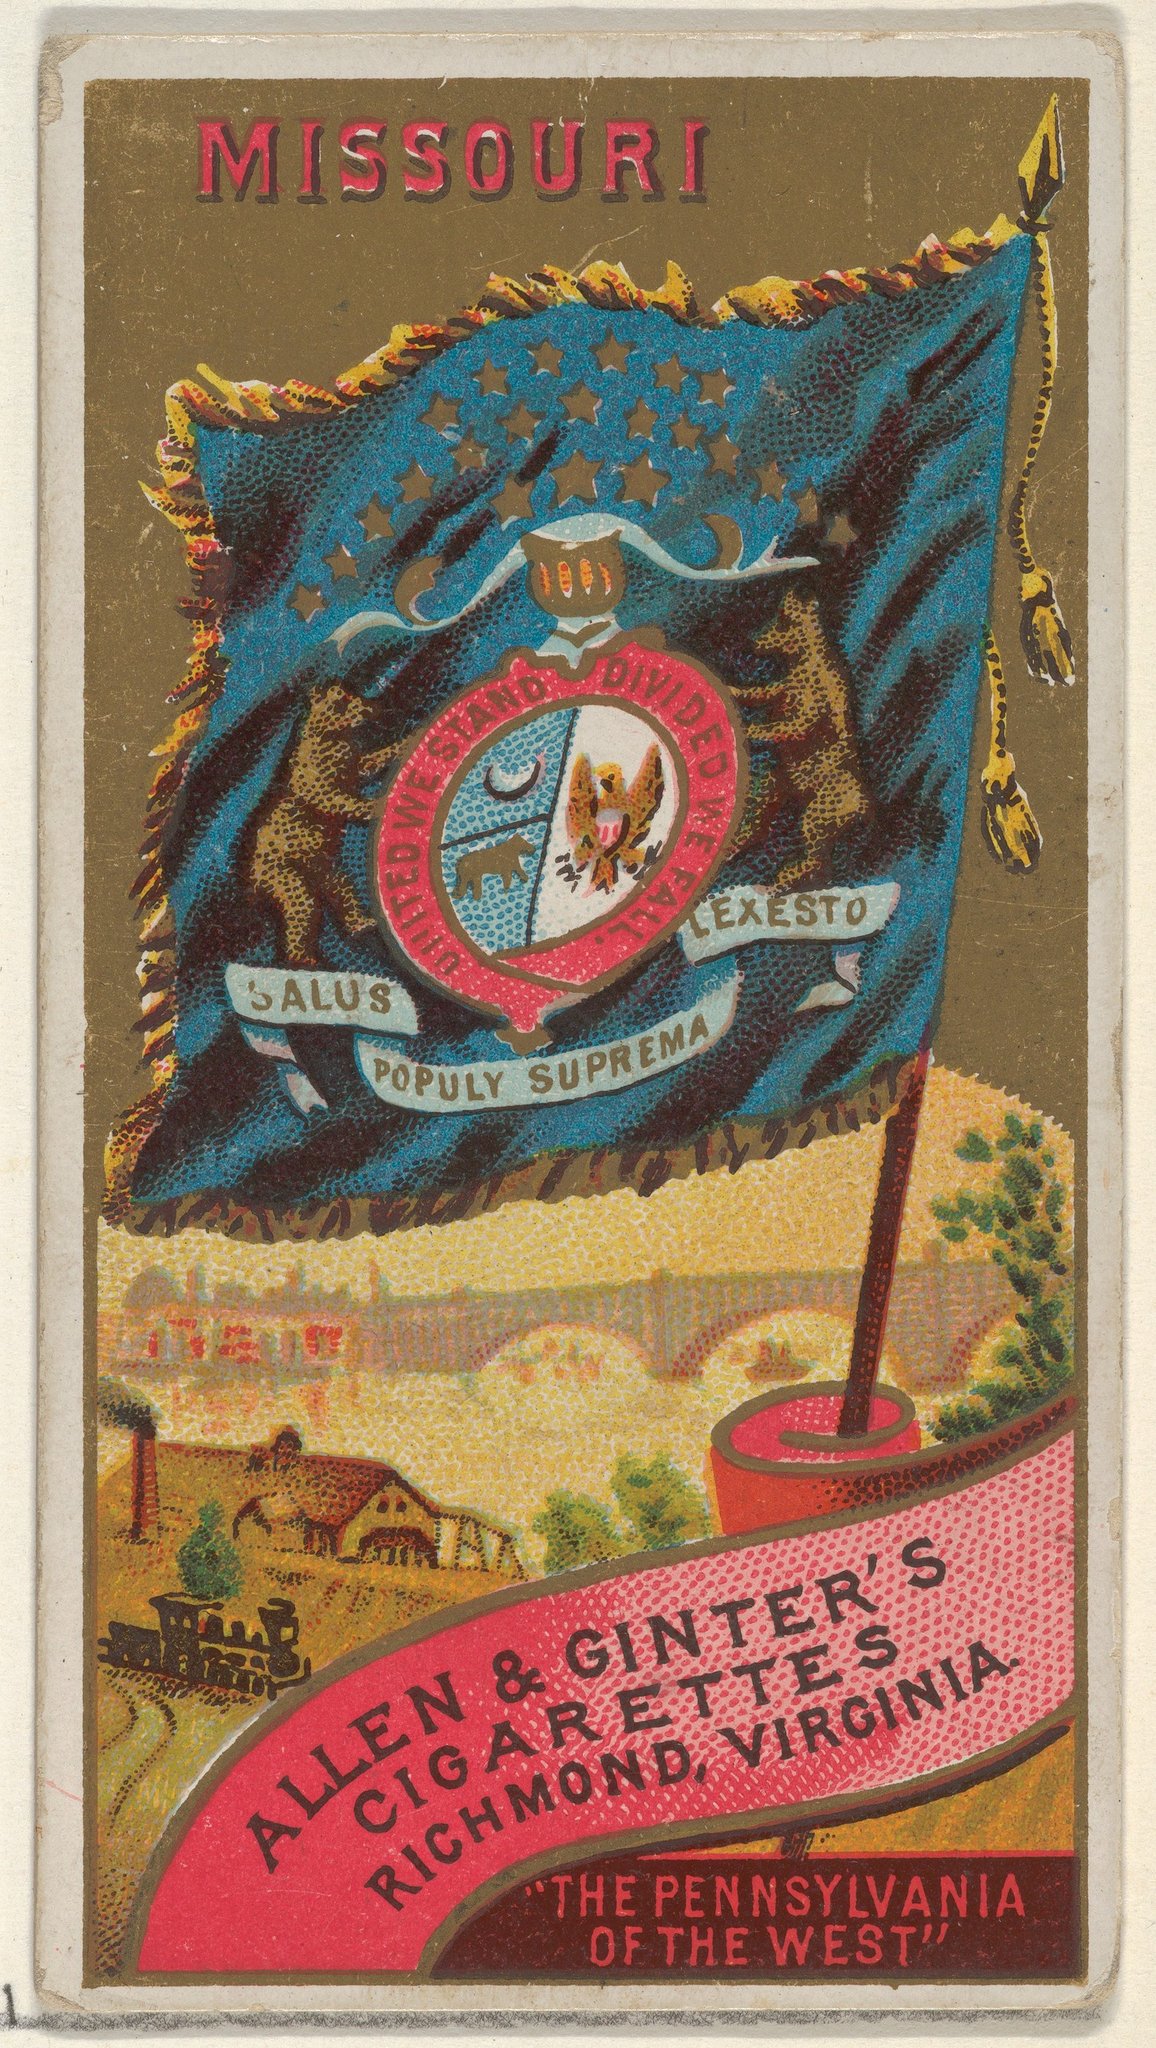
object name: print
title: Missouri, from Flags of the States and Territories (N11) for Allen & Ginter Cigarettes Brands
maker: allen & ginter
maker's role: publisher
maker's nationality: american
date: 1888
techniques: color lithograph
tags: coat of arms,flags